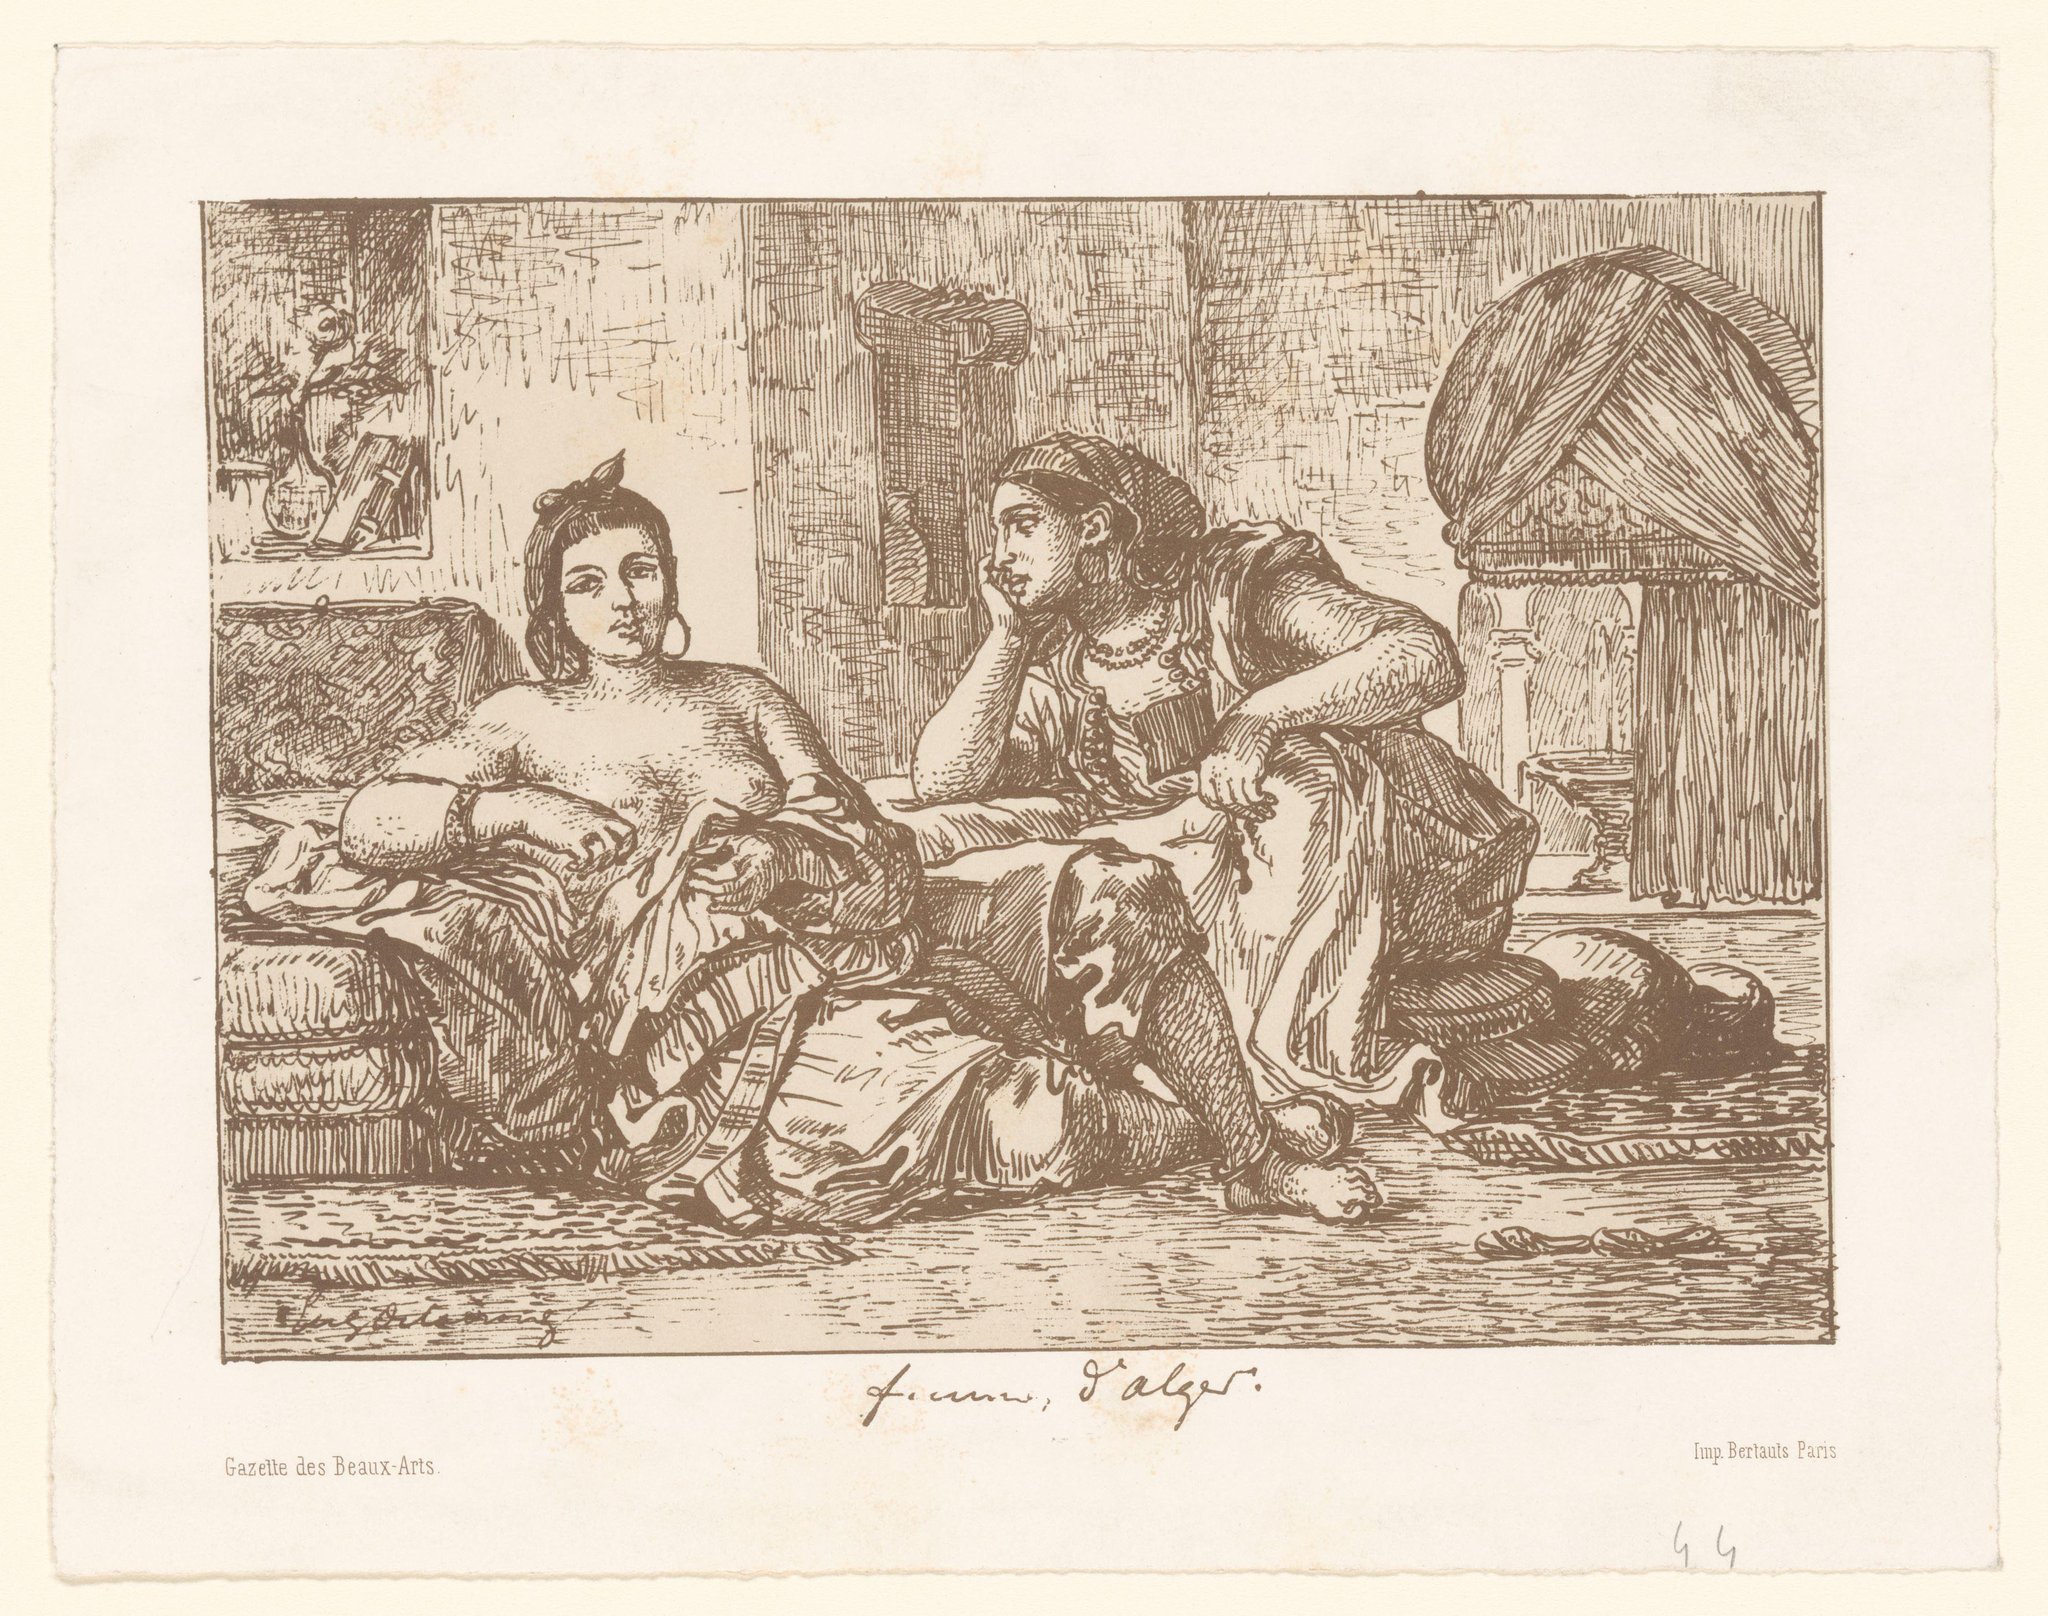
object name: print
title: Twee zittende Algerijnse vrouwen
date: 1833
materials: paper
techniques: pen lithography, tone lithography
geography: paris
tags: adult woman, sitting on the ground - aa - female human figure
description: Prent gebruikt voor: La Gazette des Beaux-Arts 19 (1833).